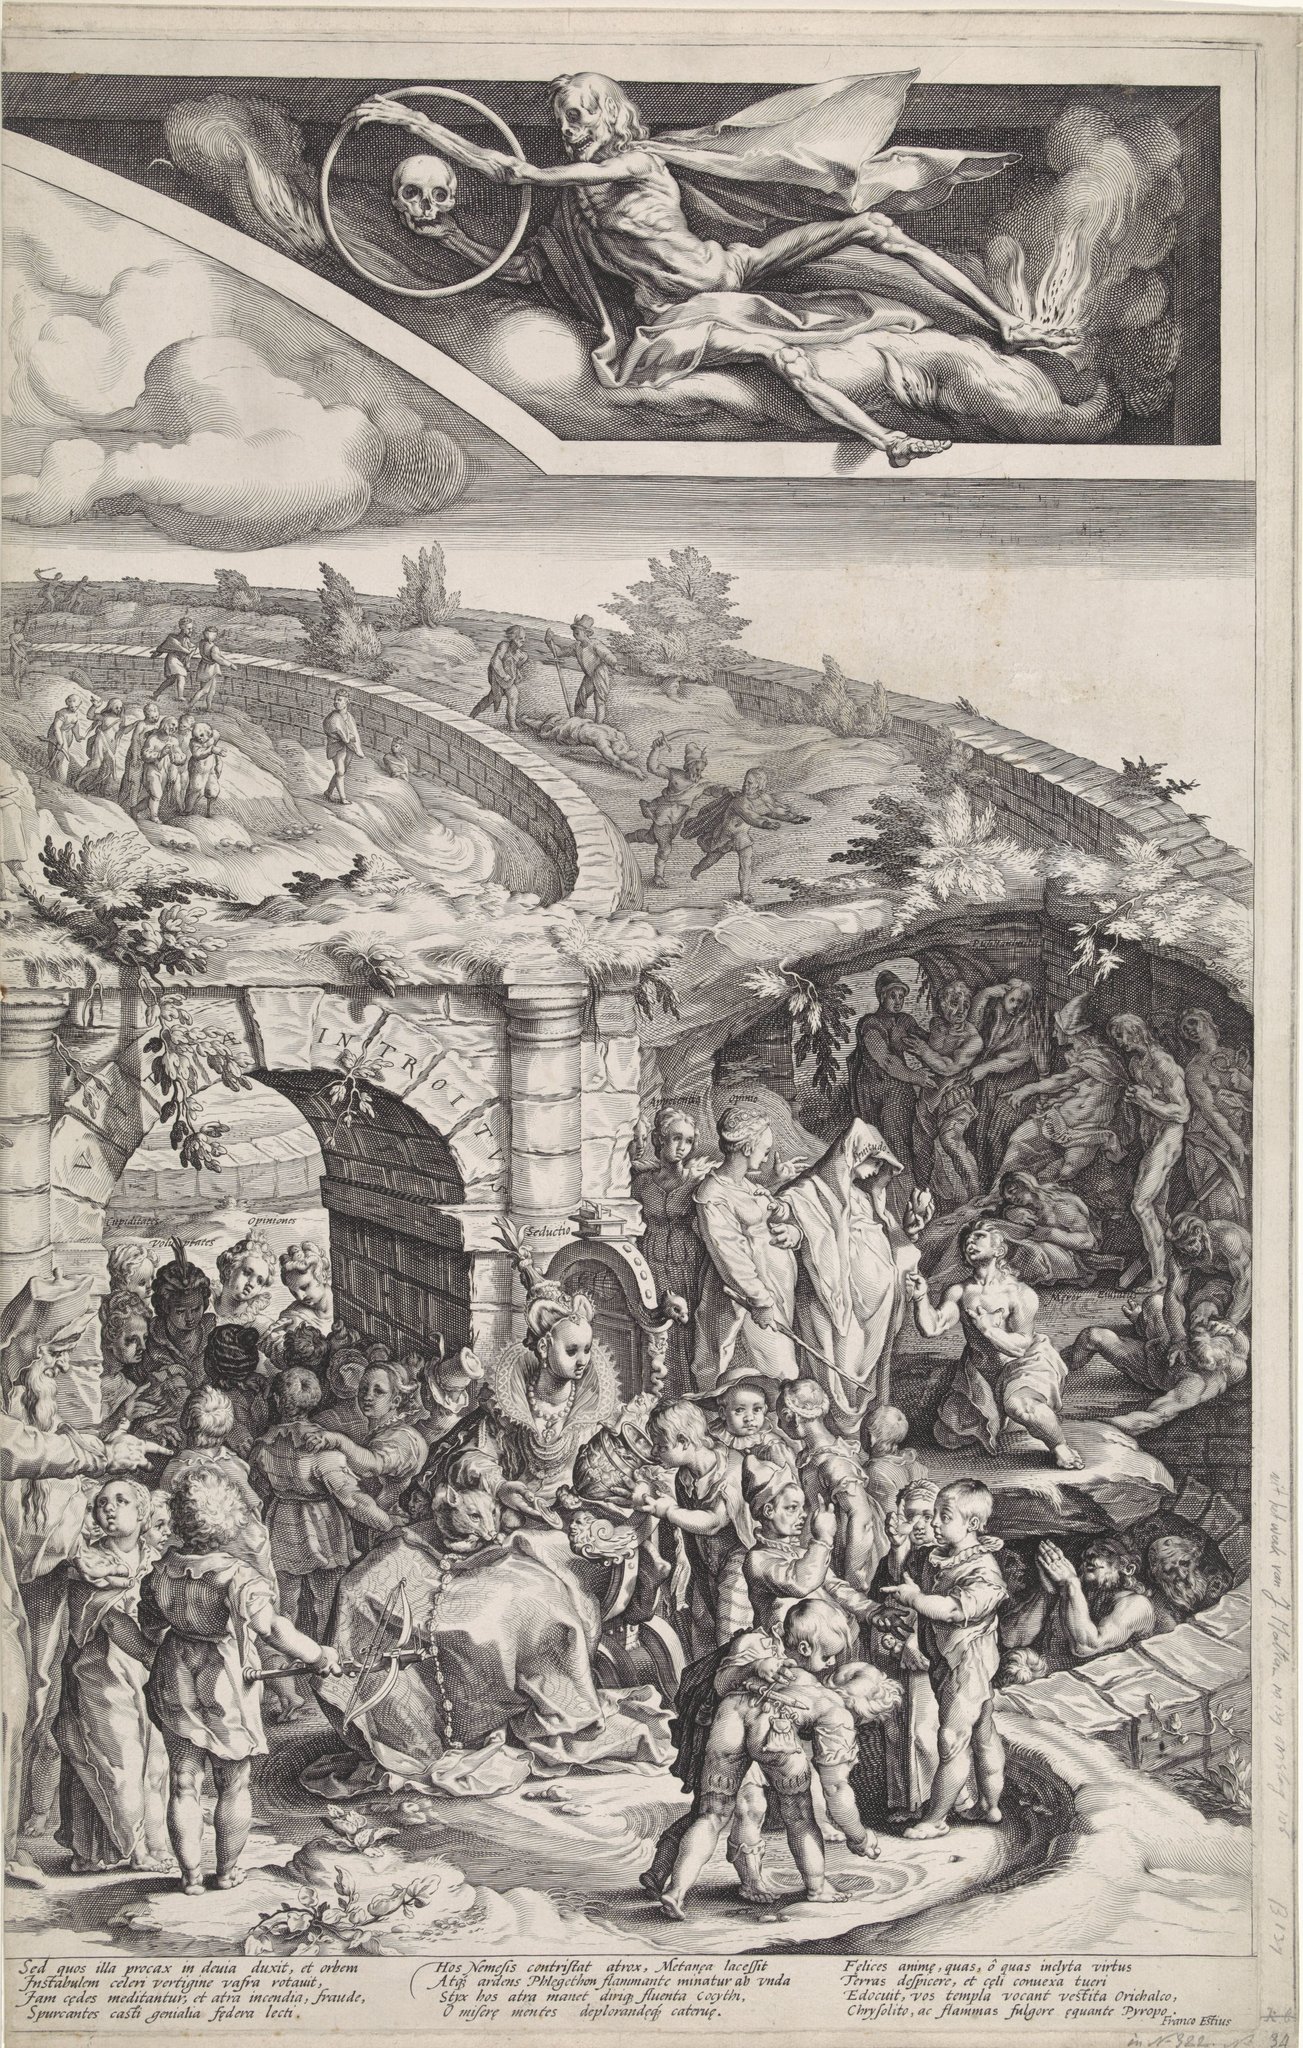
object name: print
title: Tabula Cebetis, rechter blad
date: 1592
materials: paper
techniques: engraving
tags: 'tabula cebetis'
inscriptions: collector's mark: Lugt 240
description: Tafel van Cebes. Allegorische voorstelling van de levensweg als de passage door concentrische ringen naar de tempel van geluk op een berg in het midden. Gedetailleerde voorstelling met talloze personen en allegorische figuren met opschriften.